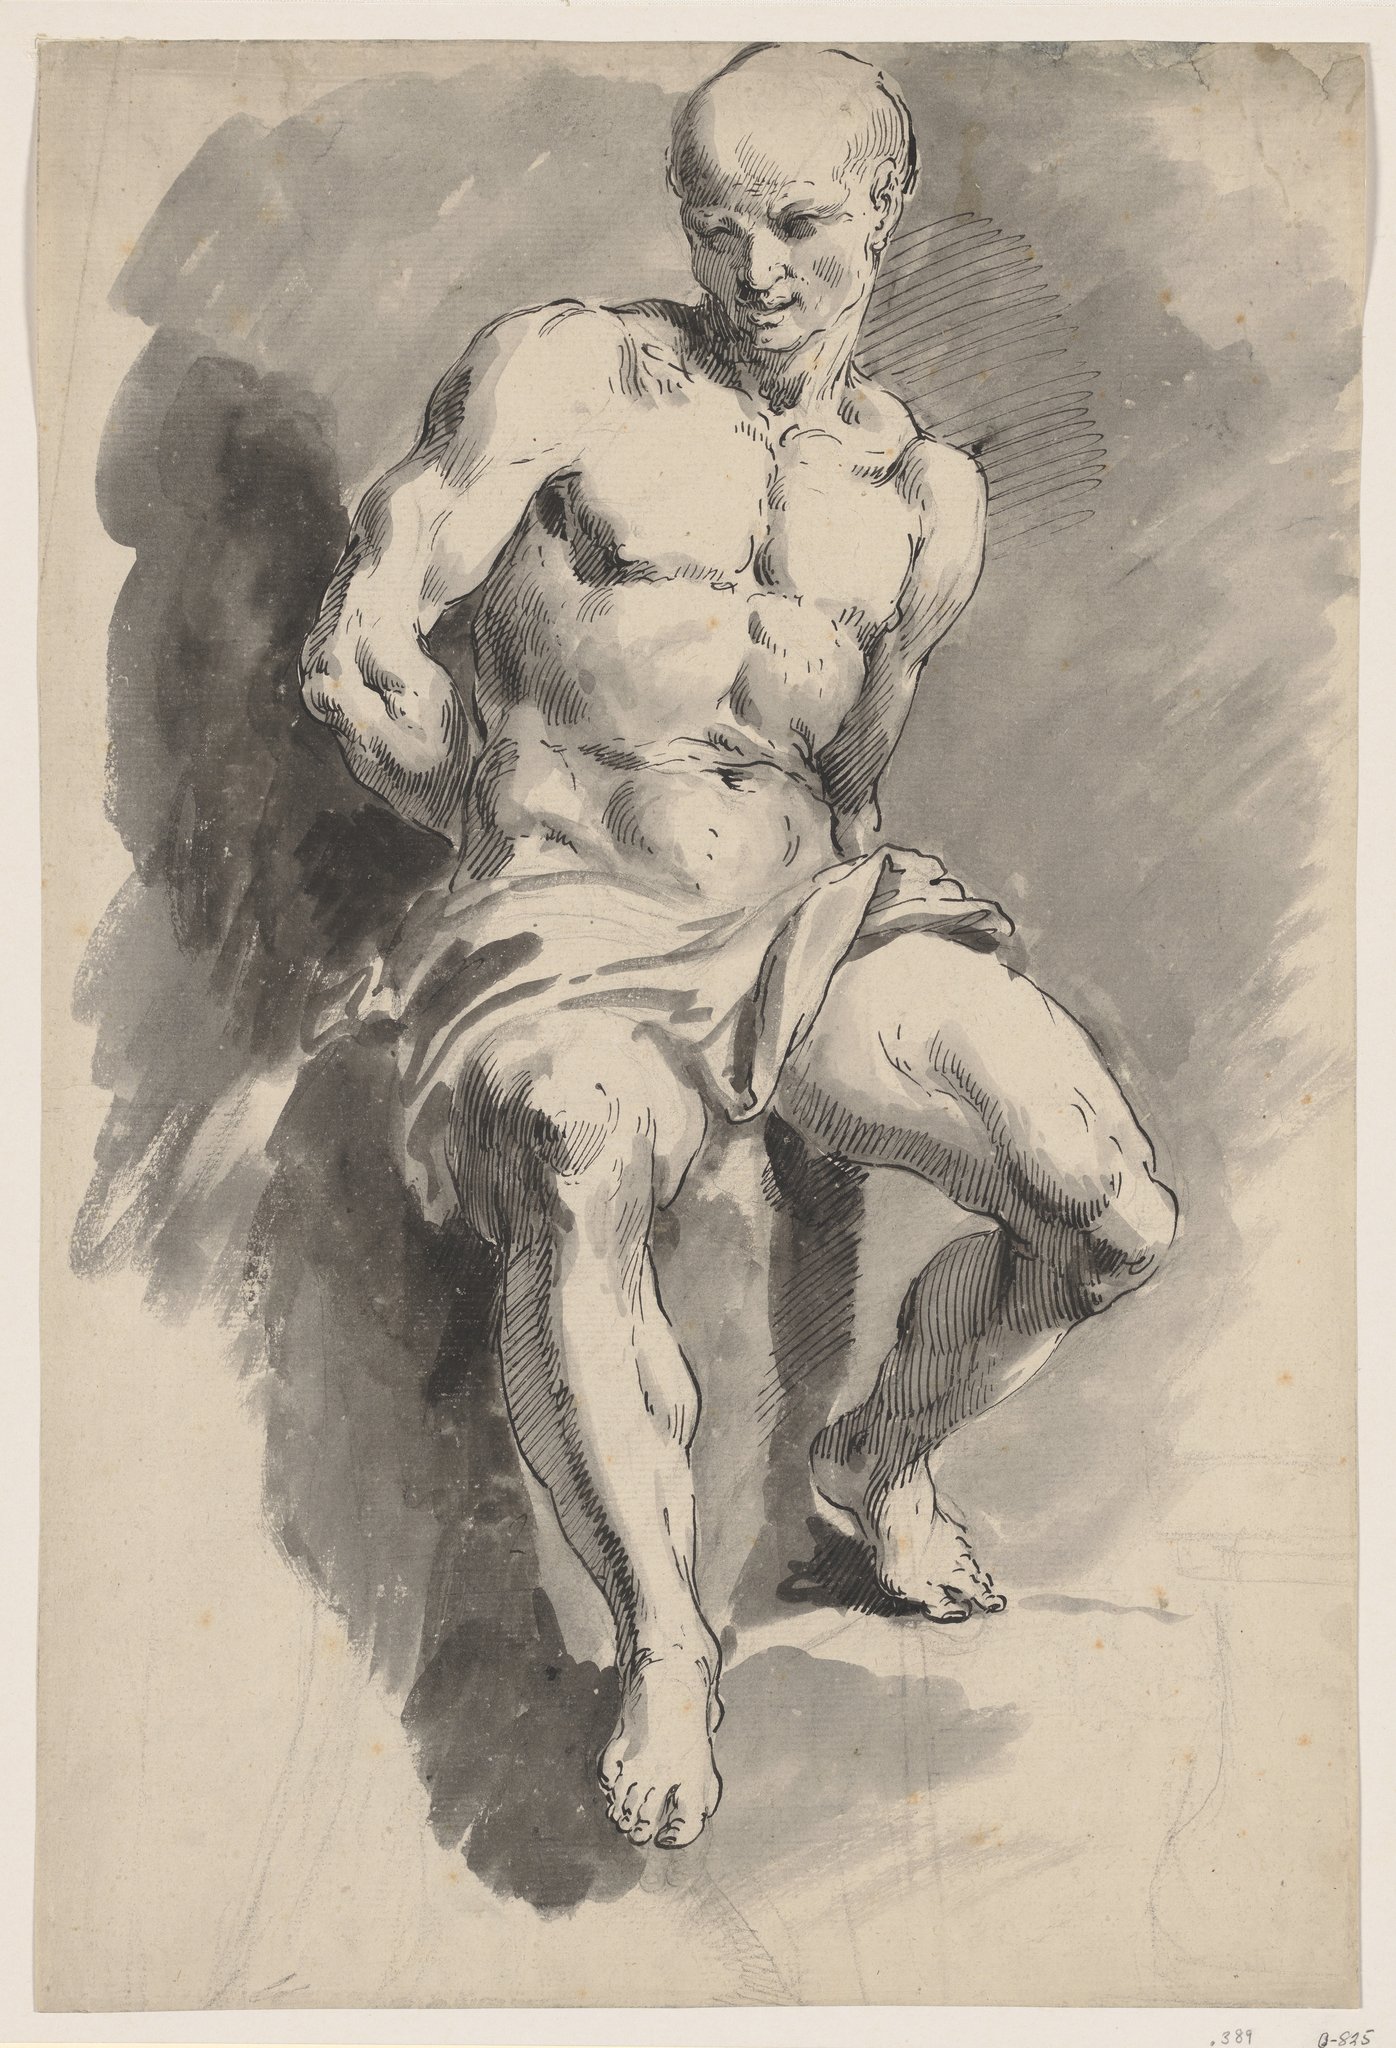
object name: drawing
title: A Seated Slave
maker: pietro antonio novelli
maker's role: artist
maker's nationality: italian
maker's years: 1729-1804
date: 1734-1833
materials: chalk, ink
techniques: pen, wash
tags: men,slaves